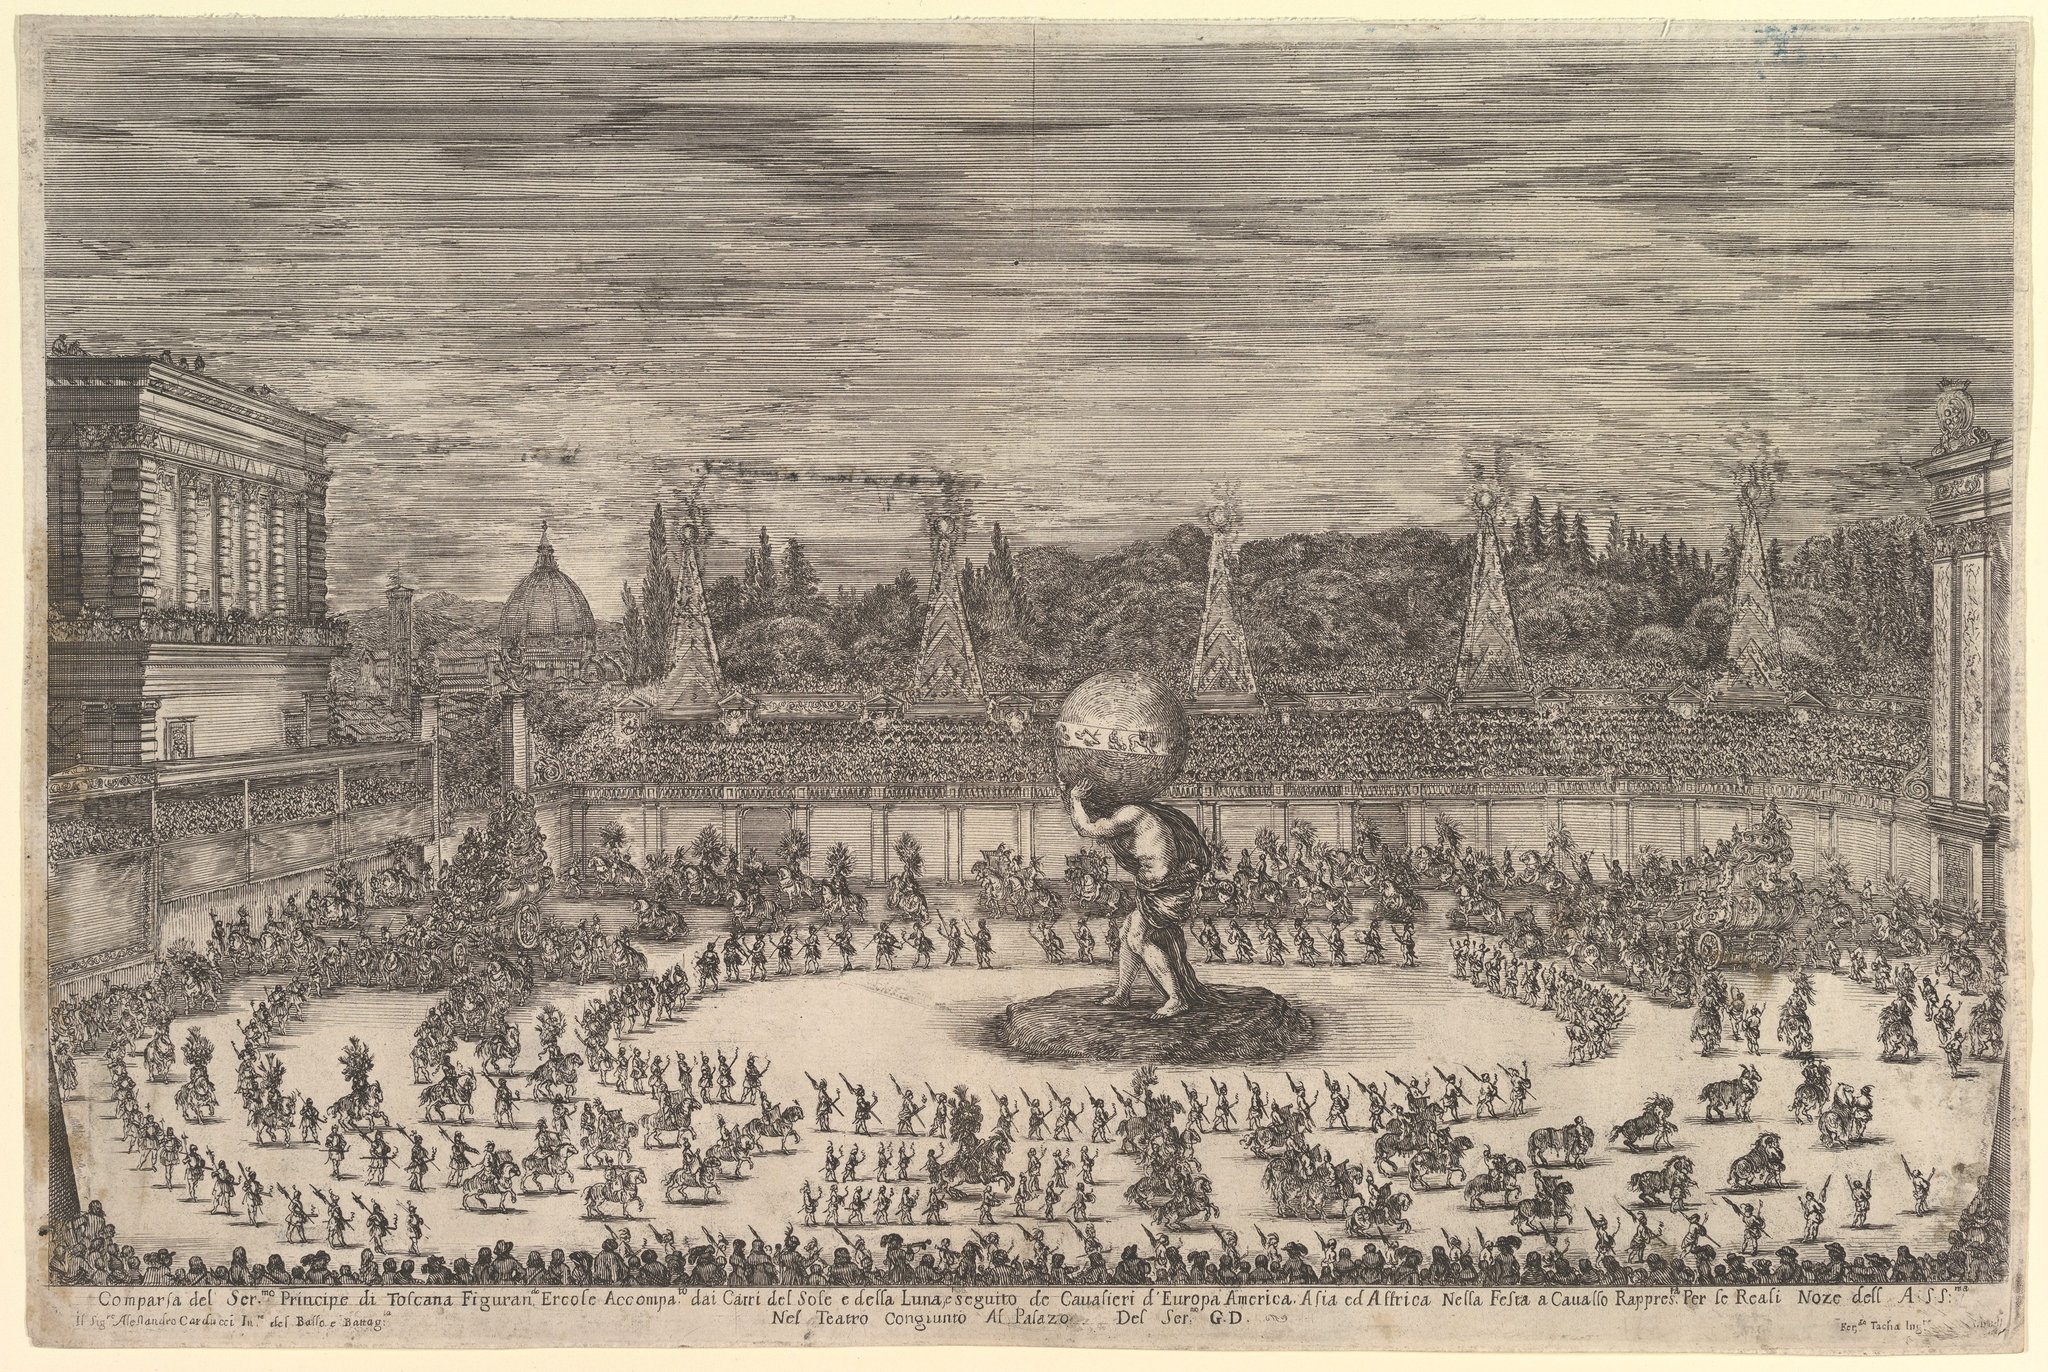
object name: print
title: Entry of the Prince of Tuscany as Hercules, from "Il mondo festeggiante"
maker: stefano della bella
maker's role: artist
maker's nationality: italian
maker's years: 1610-1664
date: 1661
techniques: etching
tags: soldiers,princes,spectators,hercules,horses